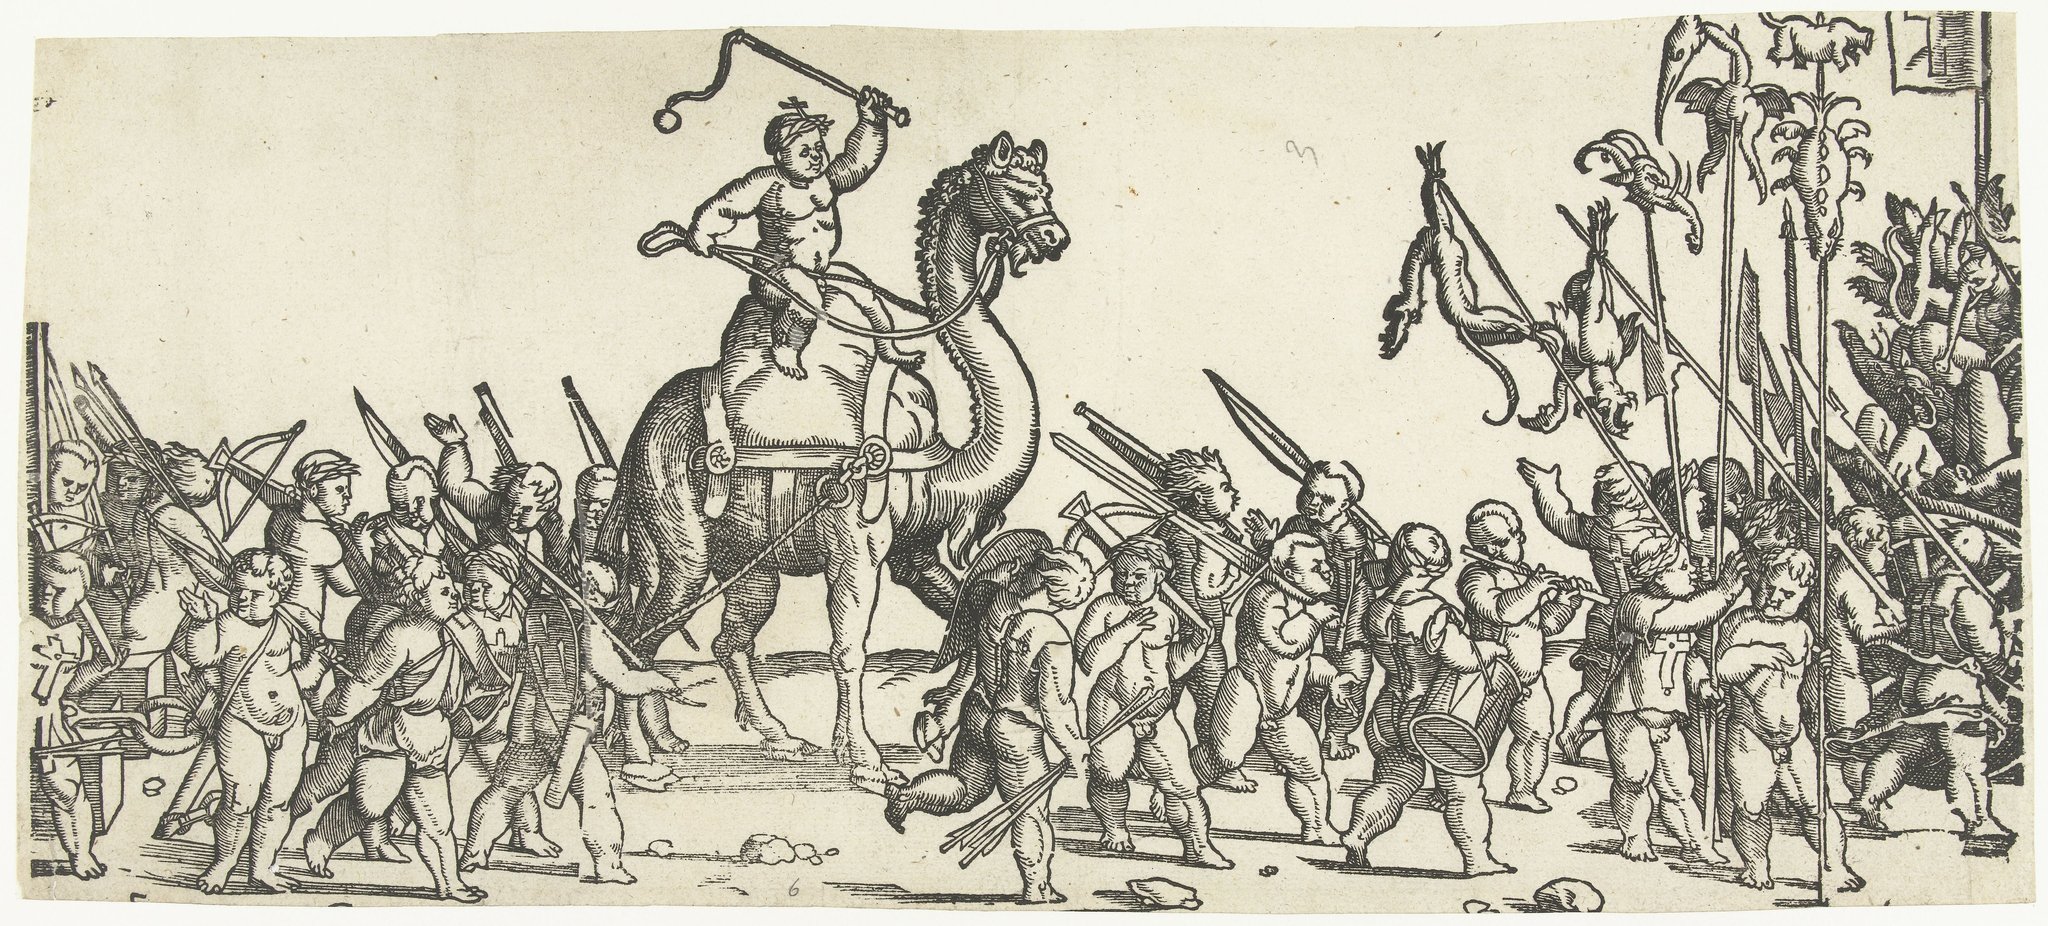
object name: print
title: Kinderkruistocht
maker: monogrammist liw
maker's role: print maker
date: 1522-1532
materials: paper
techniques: woodcut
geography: low countries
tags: hoofed animals: dromedary, child, christian religion (+ devil(s)), militant proselytizing: religious war, crusade, etc.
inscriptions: collector's mark: Lugt 2166, collector's mark: Lugt 2166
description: Tweede blok van zes, vormen samen een fries met de kinderkruistocht. Optocht van kinderen met wapens, één kind op een dromedaris, duivels op lansen gespiest.